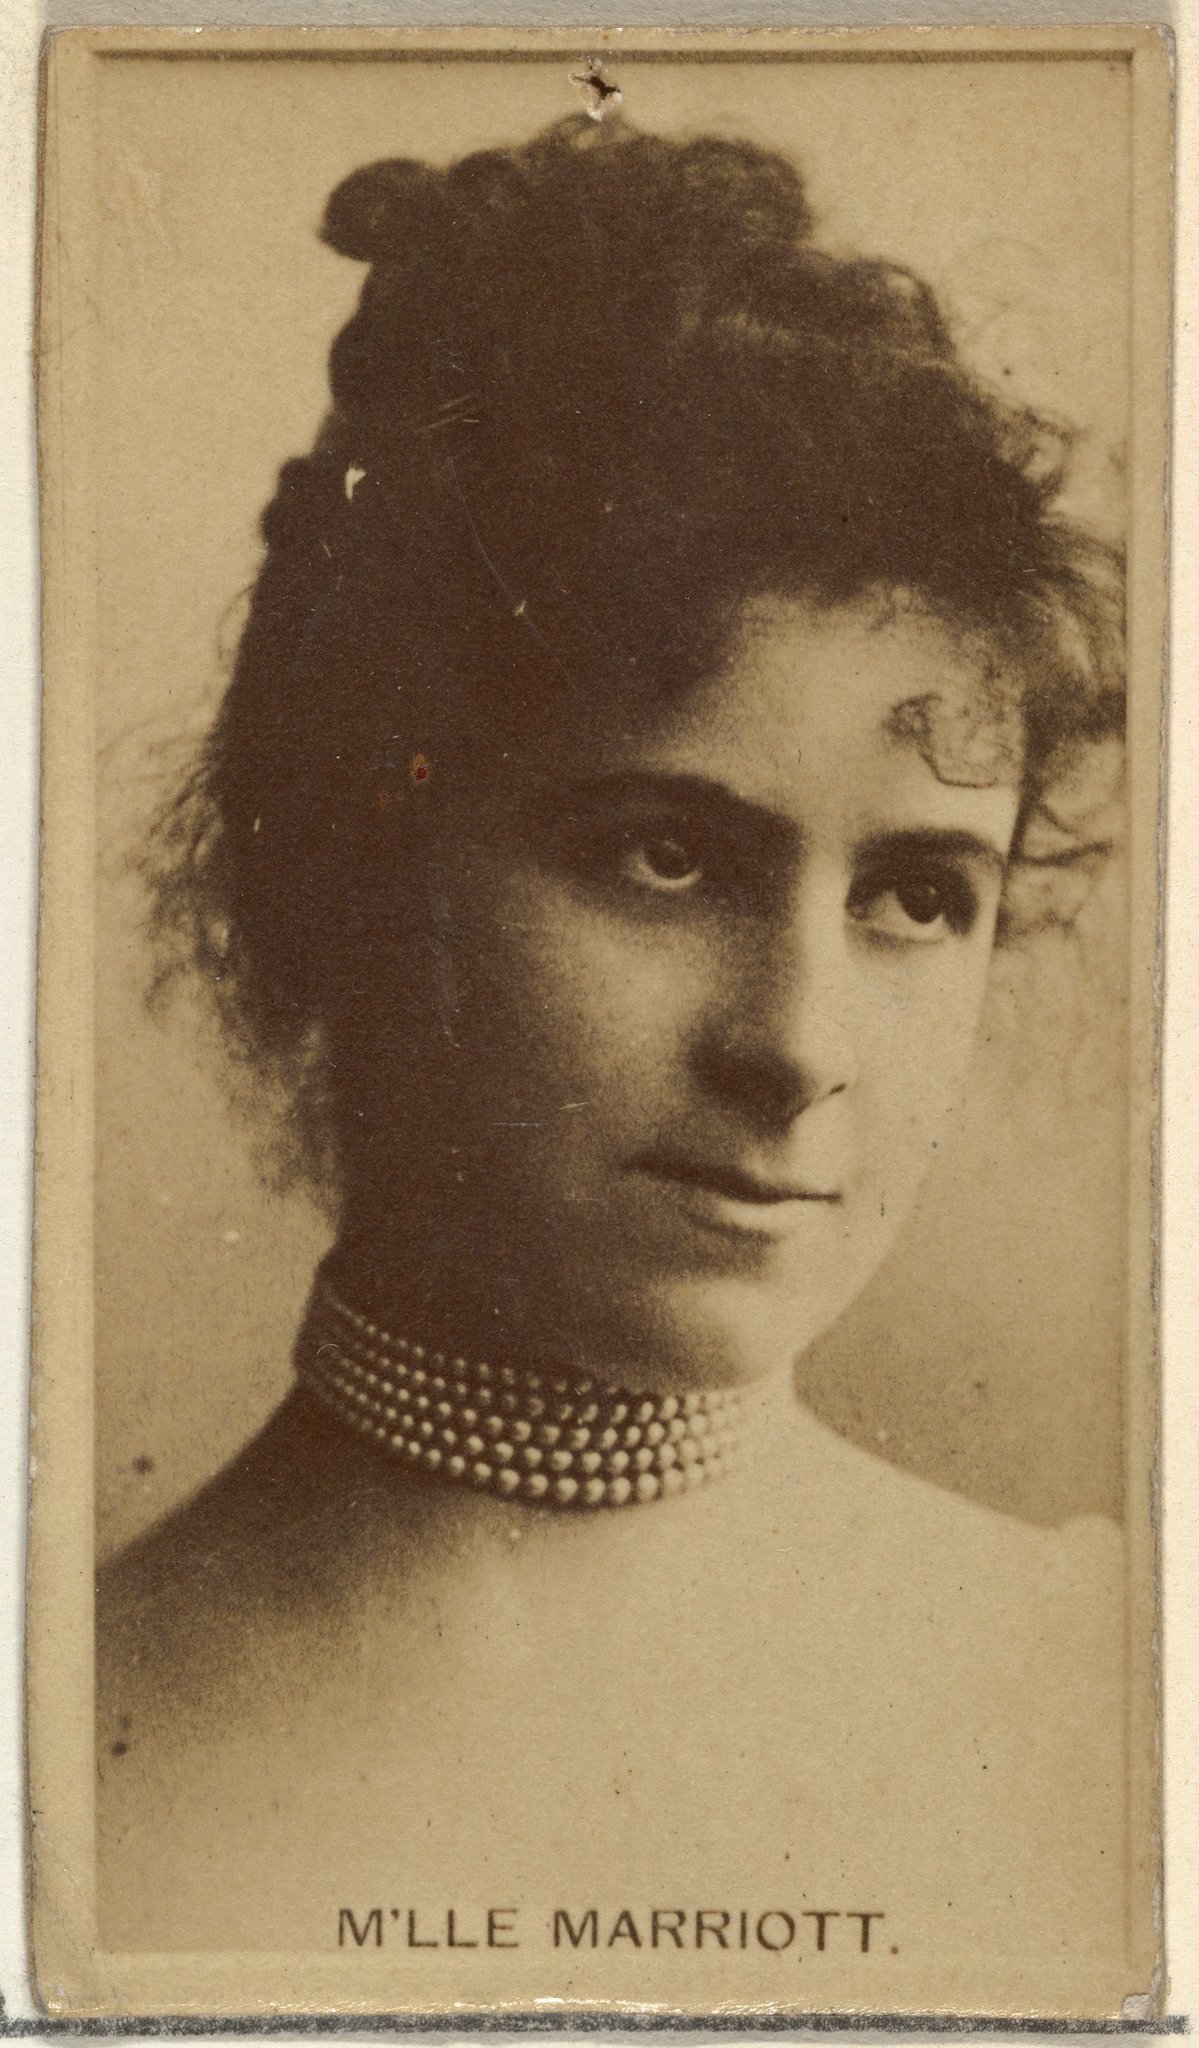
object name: photograph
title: M'lle Marriott, from the Actors and Actresses series (N145-8) issued by Duke Sons & Co. to promote Duke Cigarettes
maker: w. duke, sons & co.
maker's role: publisher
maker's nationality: american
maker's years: 1870-1920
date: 1891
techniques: albumen silver print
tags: portraits,women,actresses